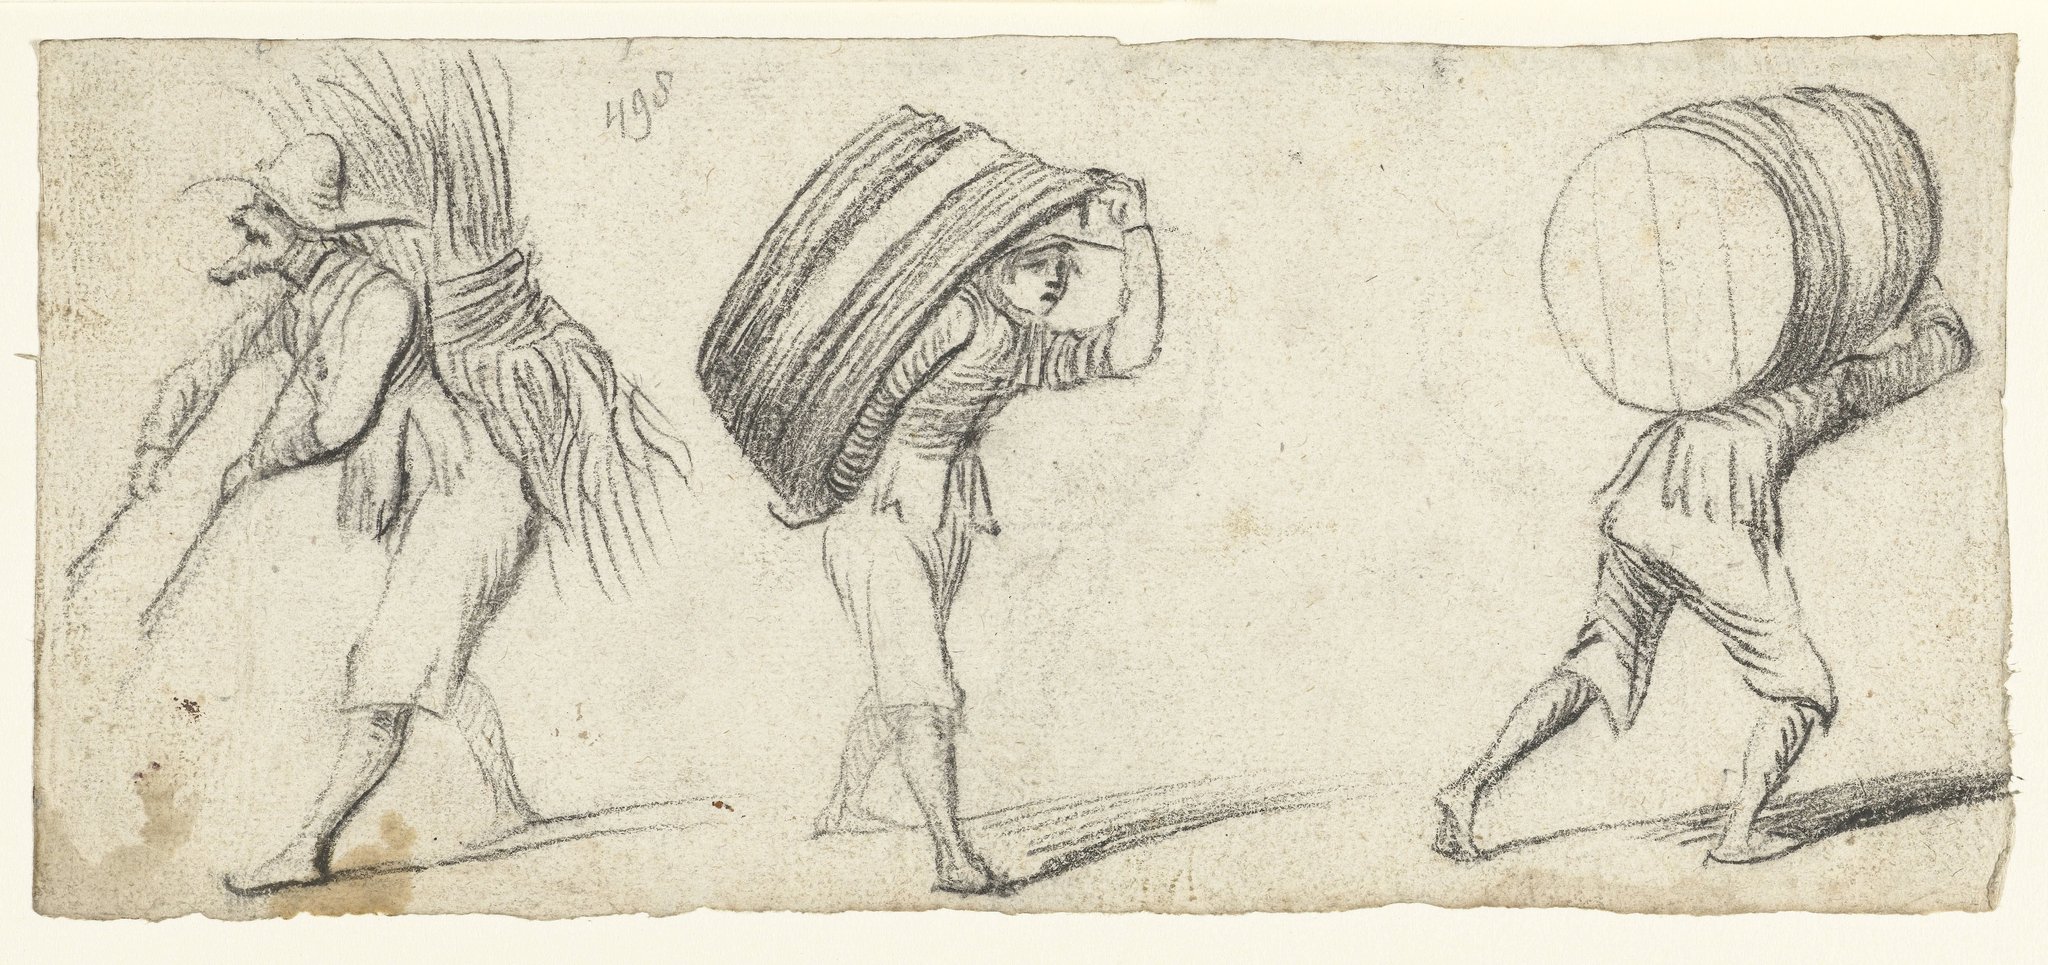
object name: drawing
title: Studieblad met drie mannen die vracht dragen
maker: harmen ter borch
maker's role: draughtsman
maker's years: 1638-1677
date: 1650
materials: chalk, paper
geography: zwolle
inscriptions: annotation: ‘Harma[n] ter Borch inventor 1650. den 19.octobr’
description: De man links draagt een takkenbos op zijn rug, de man in het midden een grote tobbe en de man rechts een ton.